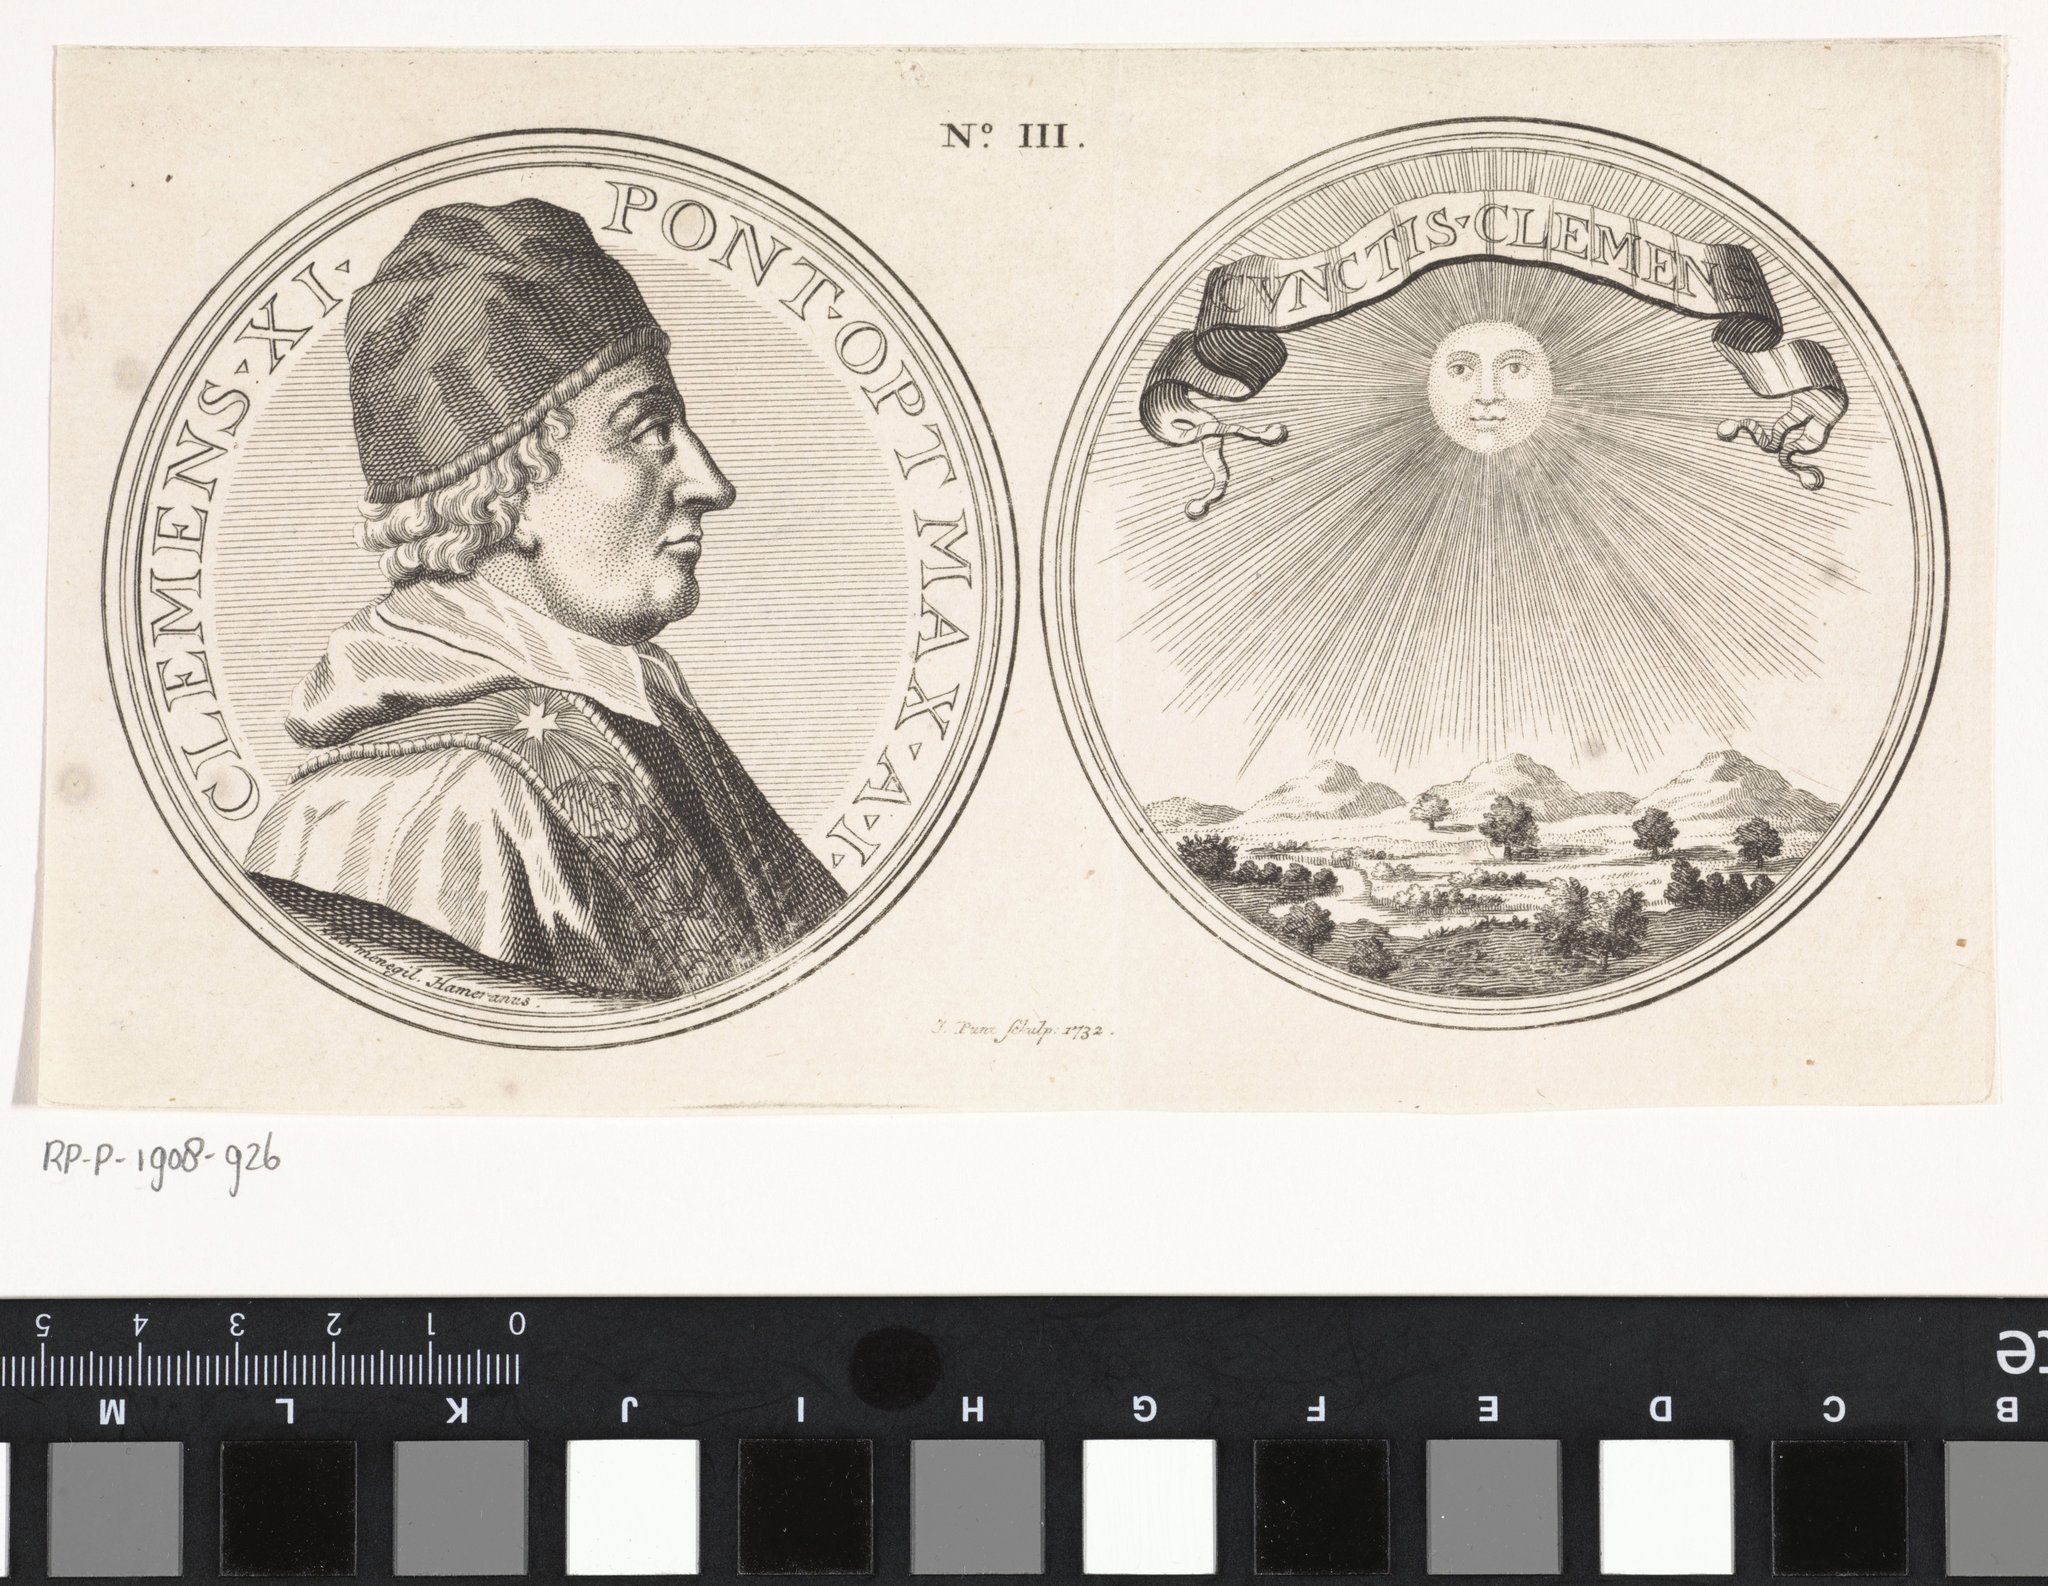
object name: print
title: Medaille met busteportret van paus Clemens XI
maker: jan punt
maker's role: draughtsman, print maker, publisher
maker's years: 1711-1779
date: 1732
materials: paper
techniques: engraving, etching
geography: amsterdam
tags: rome, clemens xi, medal (considered as a piece of sculpture, regardless of its specific function), sun represented as face, wheel, etc., pope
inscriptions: collector's mark: Lugt 2228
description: Blad met de voor- en achterzijde van een medaille. Links: Busteportret van Clemens XI. Rechts: Landschap met een stralende zon en een banderol: Cunctis Clemens. Bovenaan genummerd: N. III.